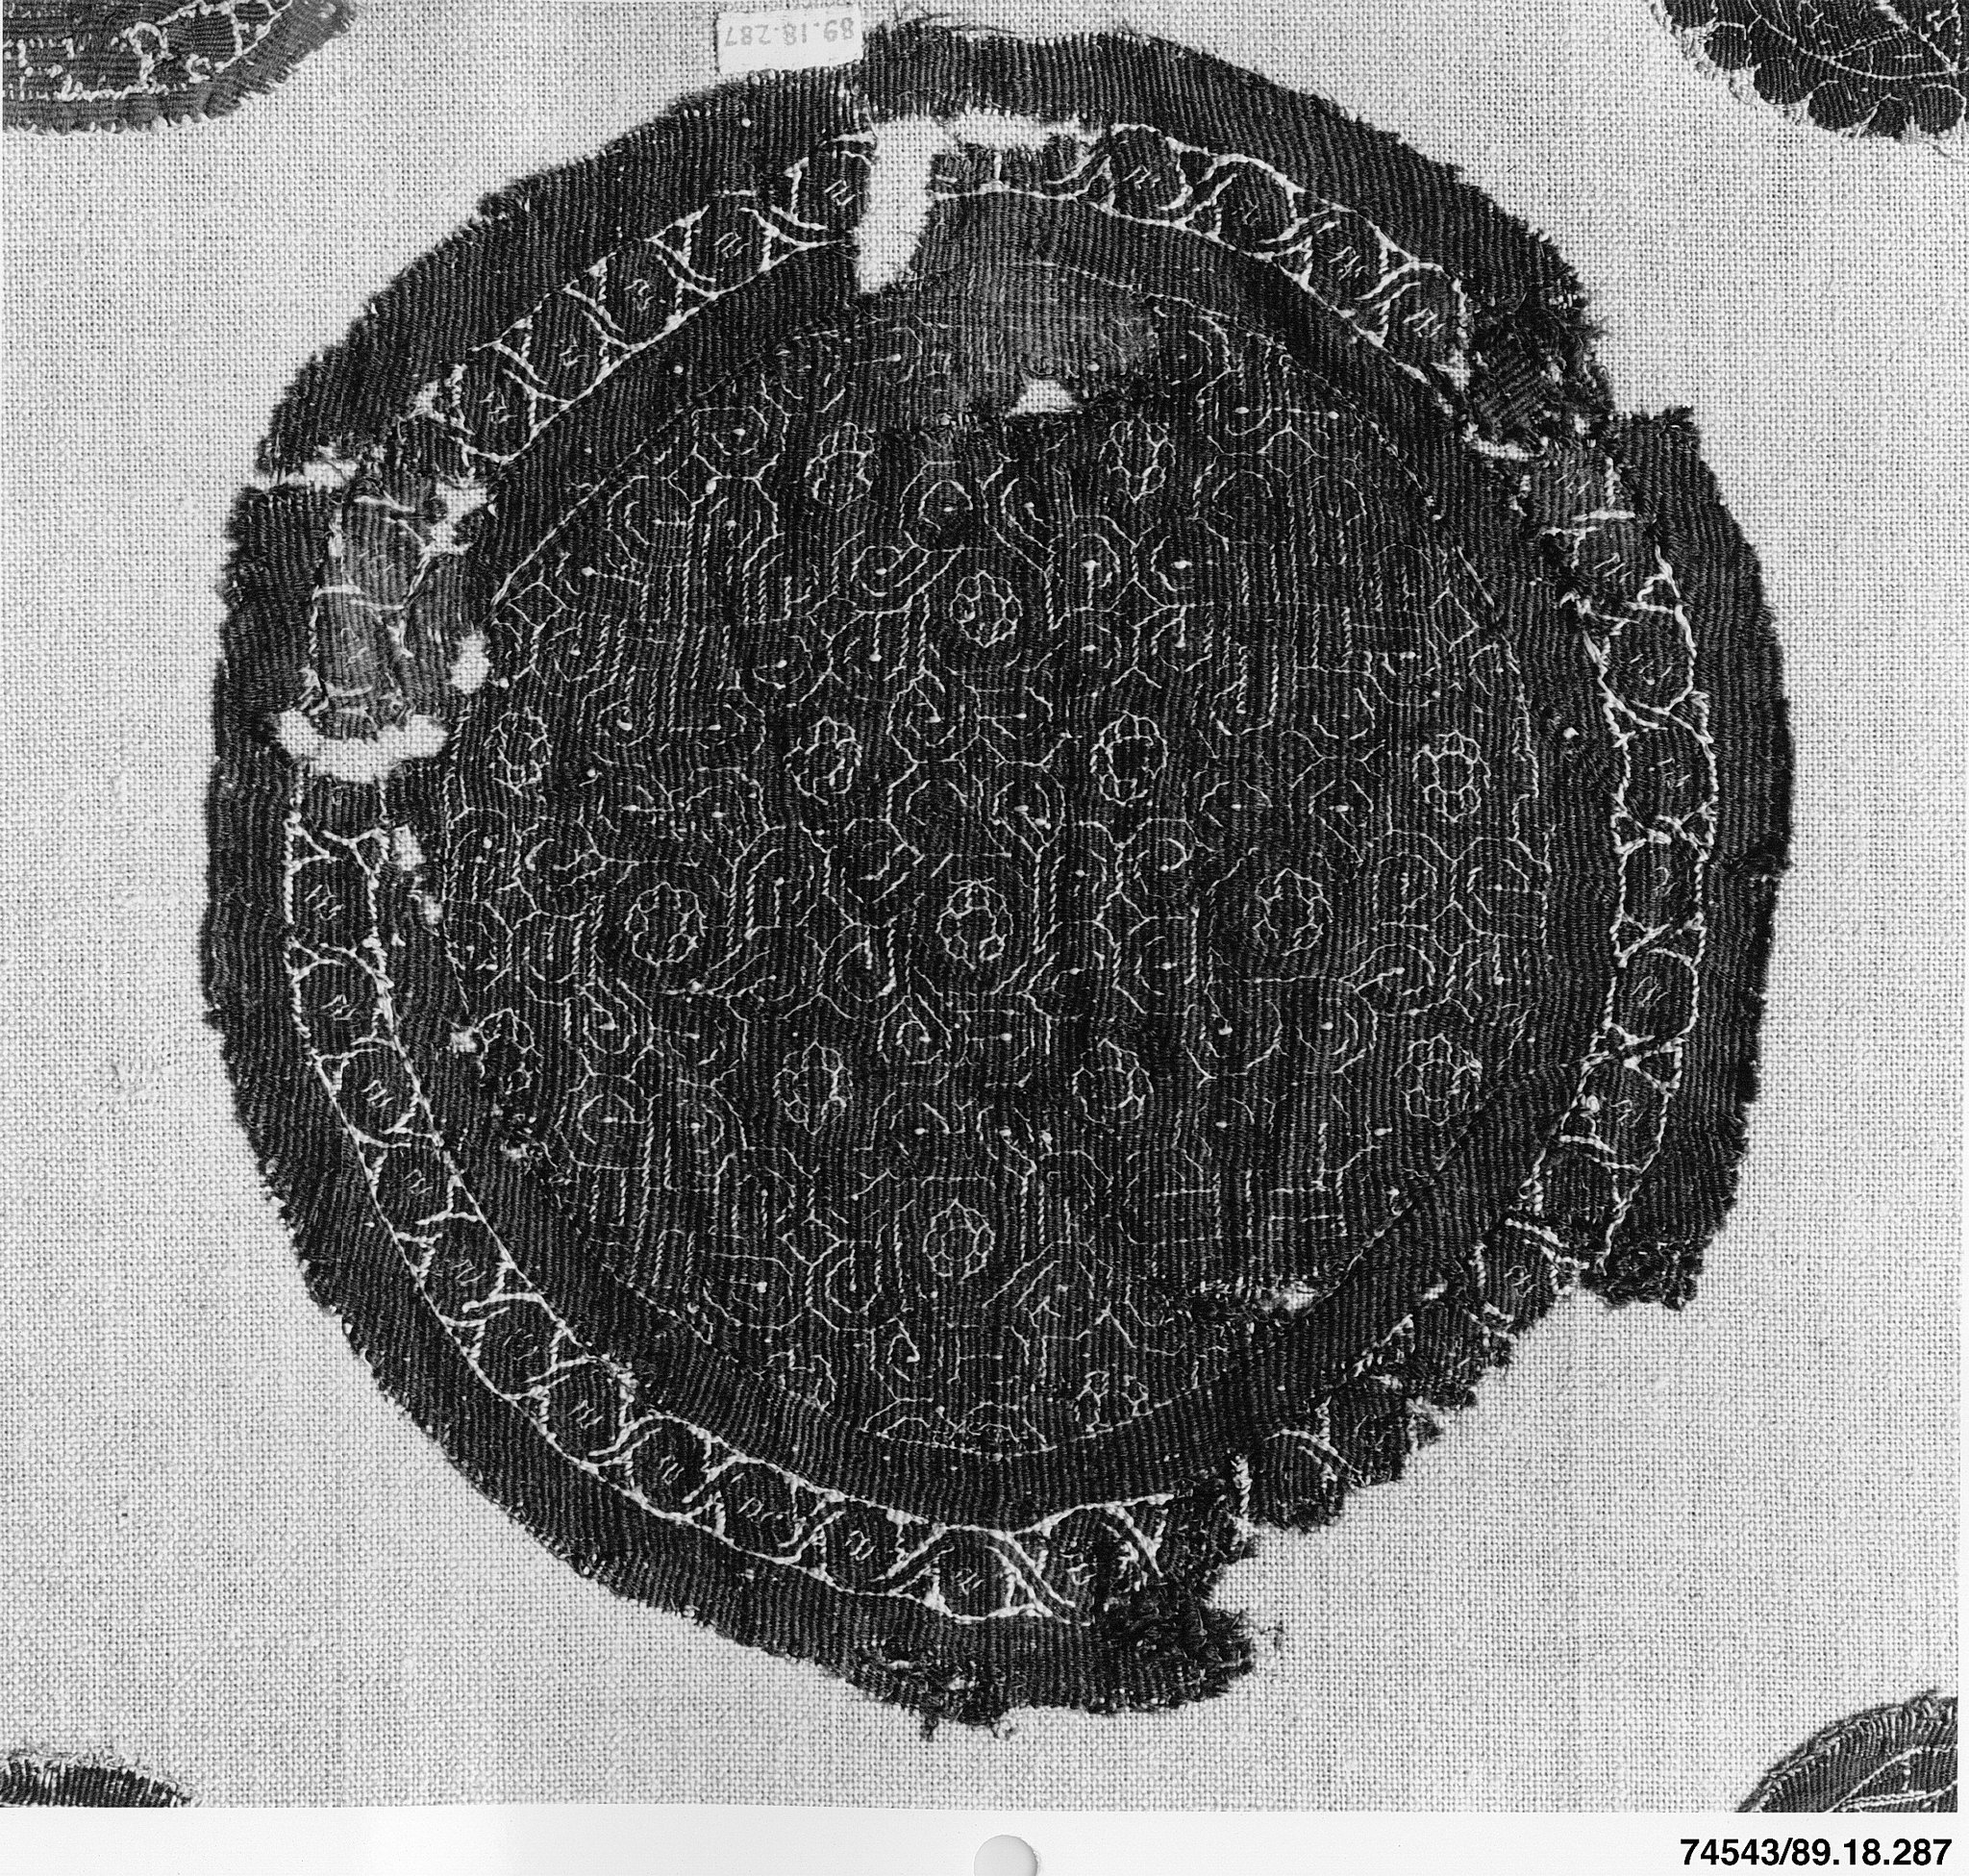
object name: textile fragment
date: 201-400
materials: linen, wool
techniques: weave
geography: egypt